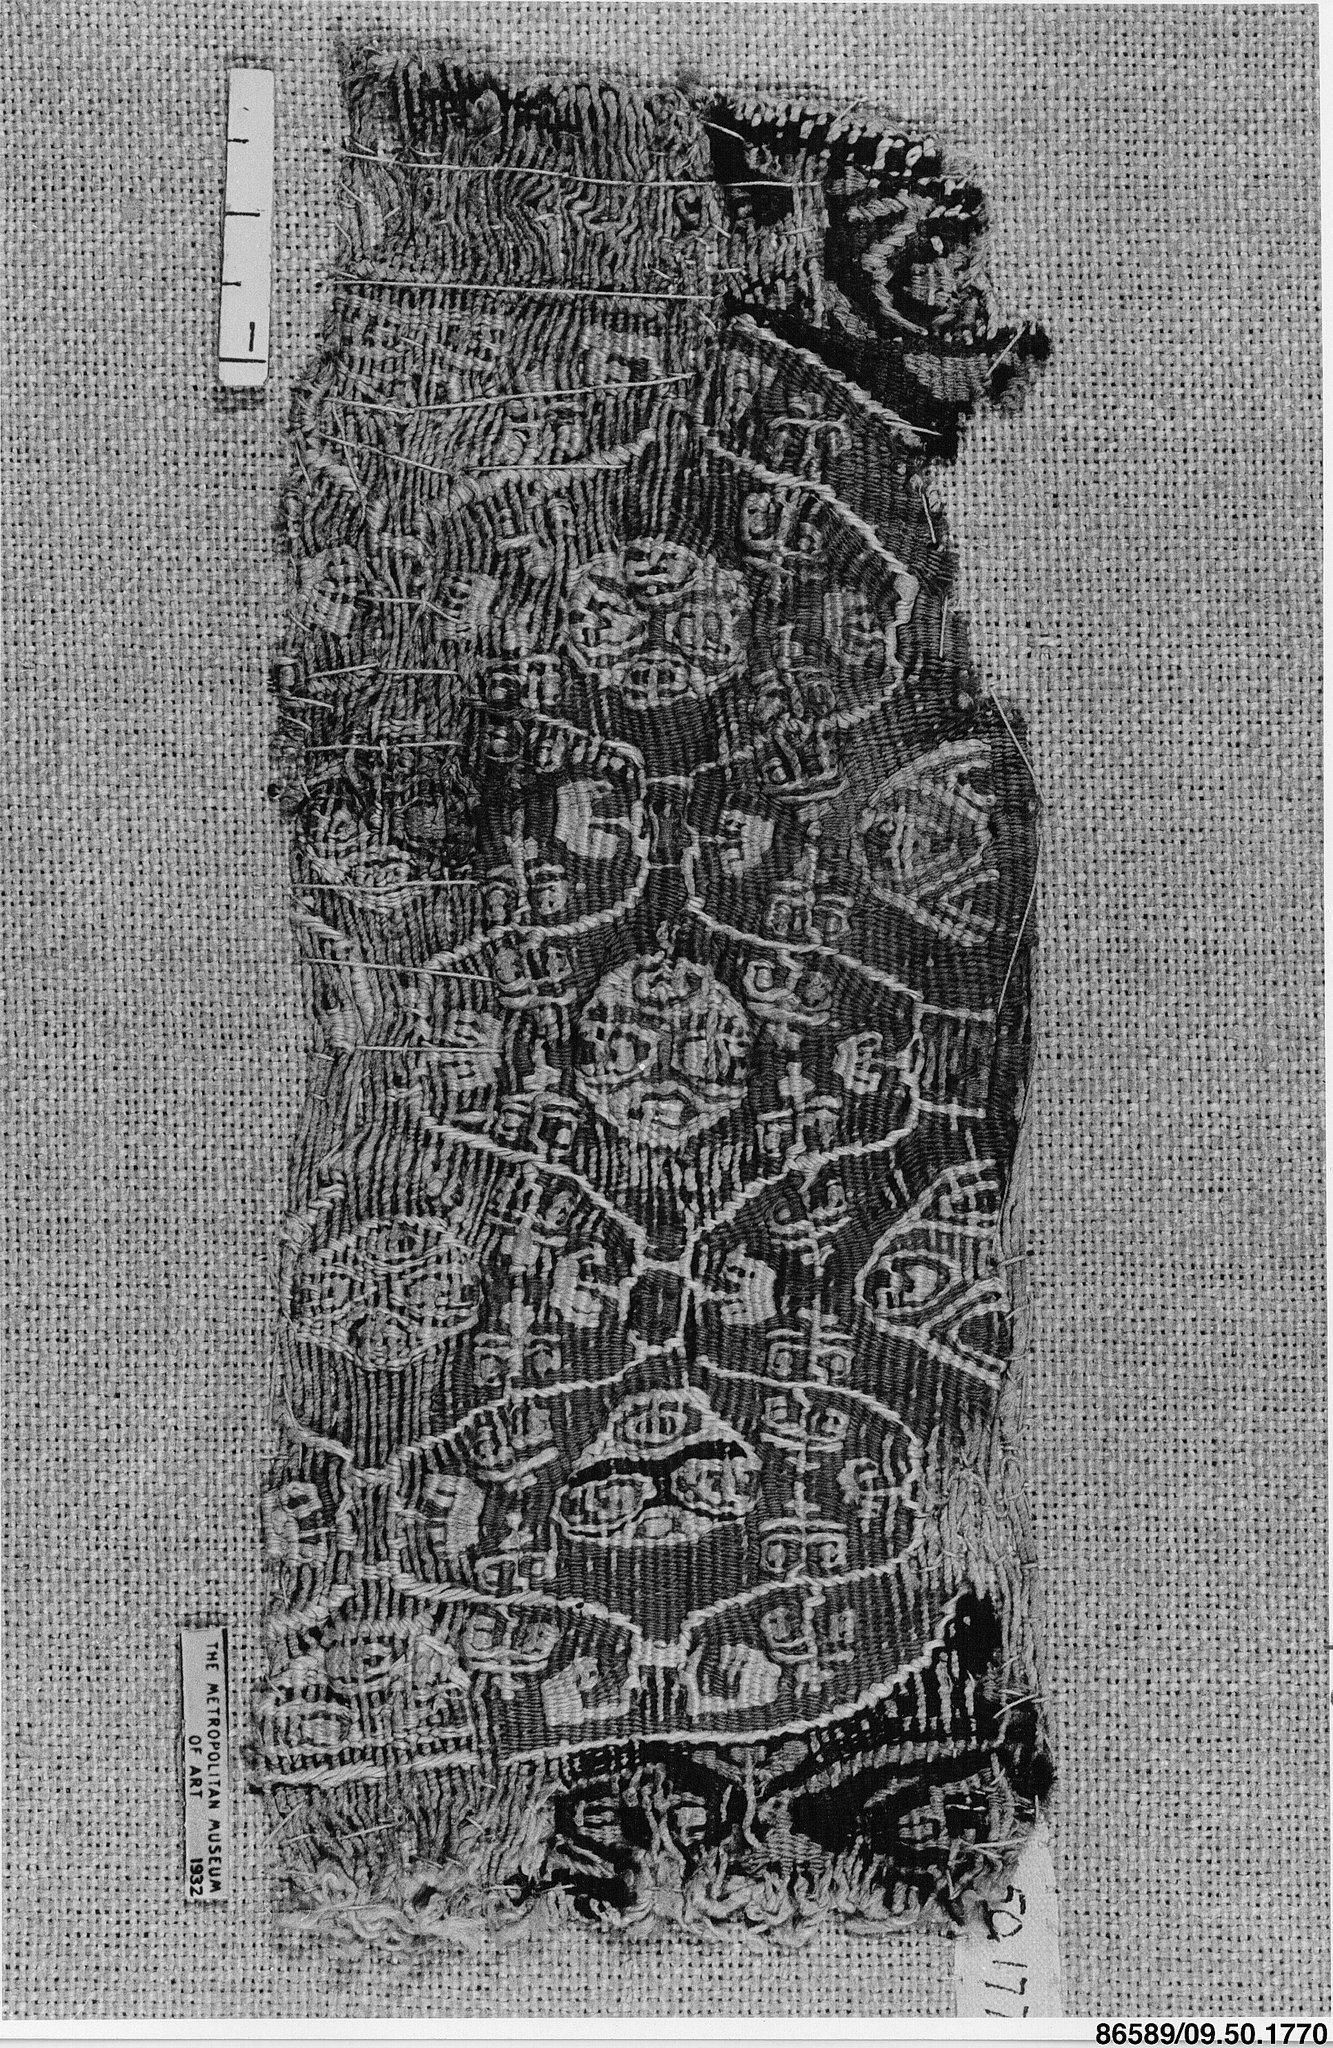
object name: textile fragment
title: Fragment of Roundel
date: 501-800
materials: linen, wool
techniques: weave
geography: egypt